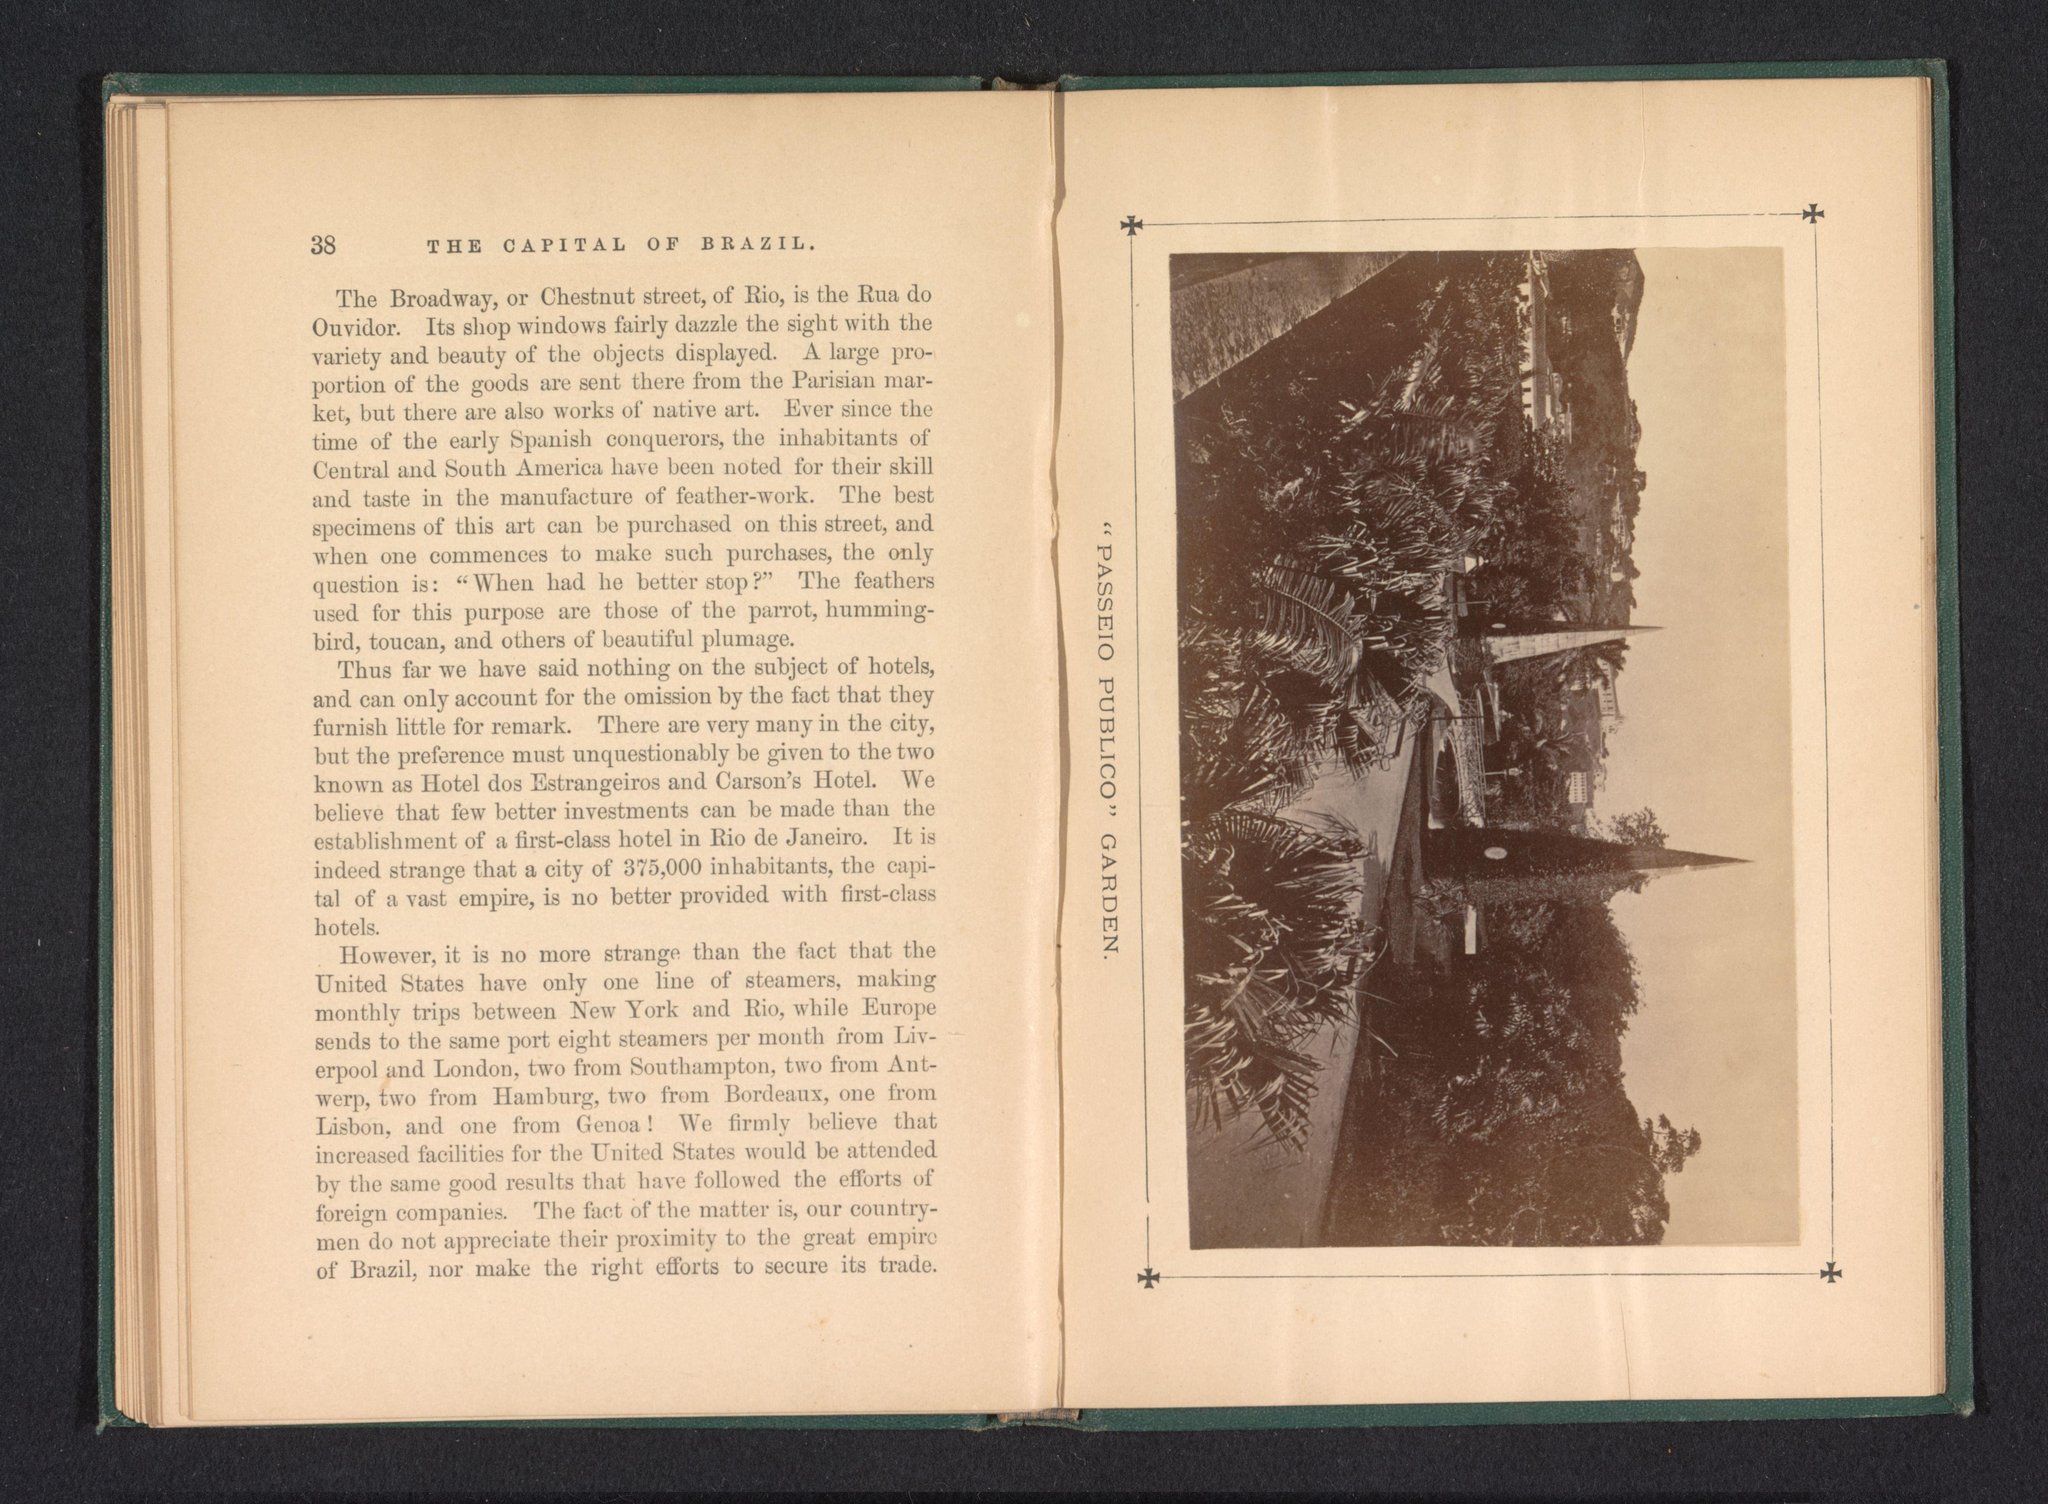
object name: photograph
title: “Passeio Publico” Garden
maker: Anonymous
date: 1864-1874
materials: photographic support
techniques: albumen print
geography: rio de janeiro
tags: public gardens, park